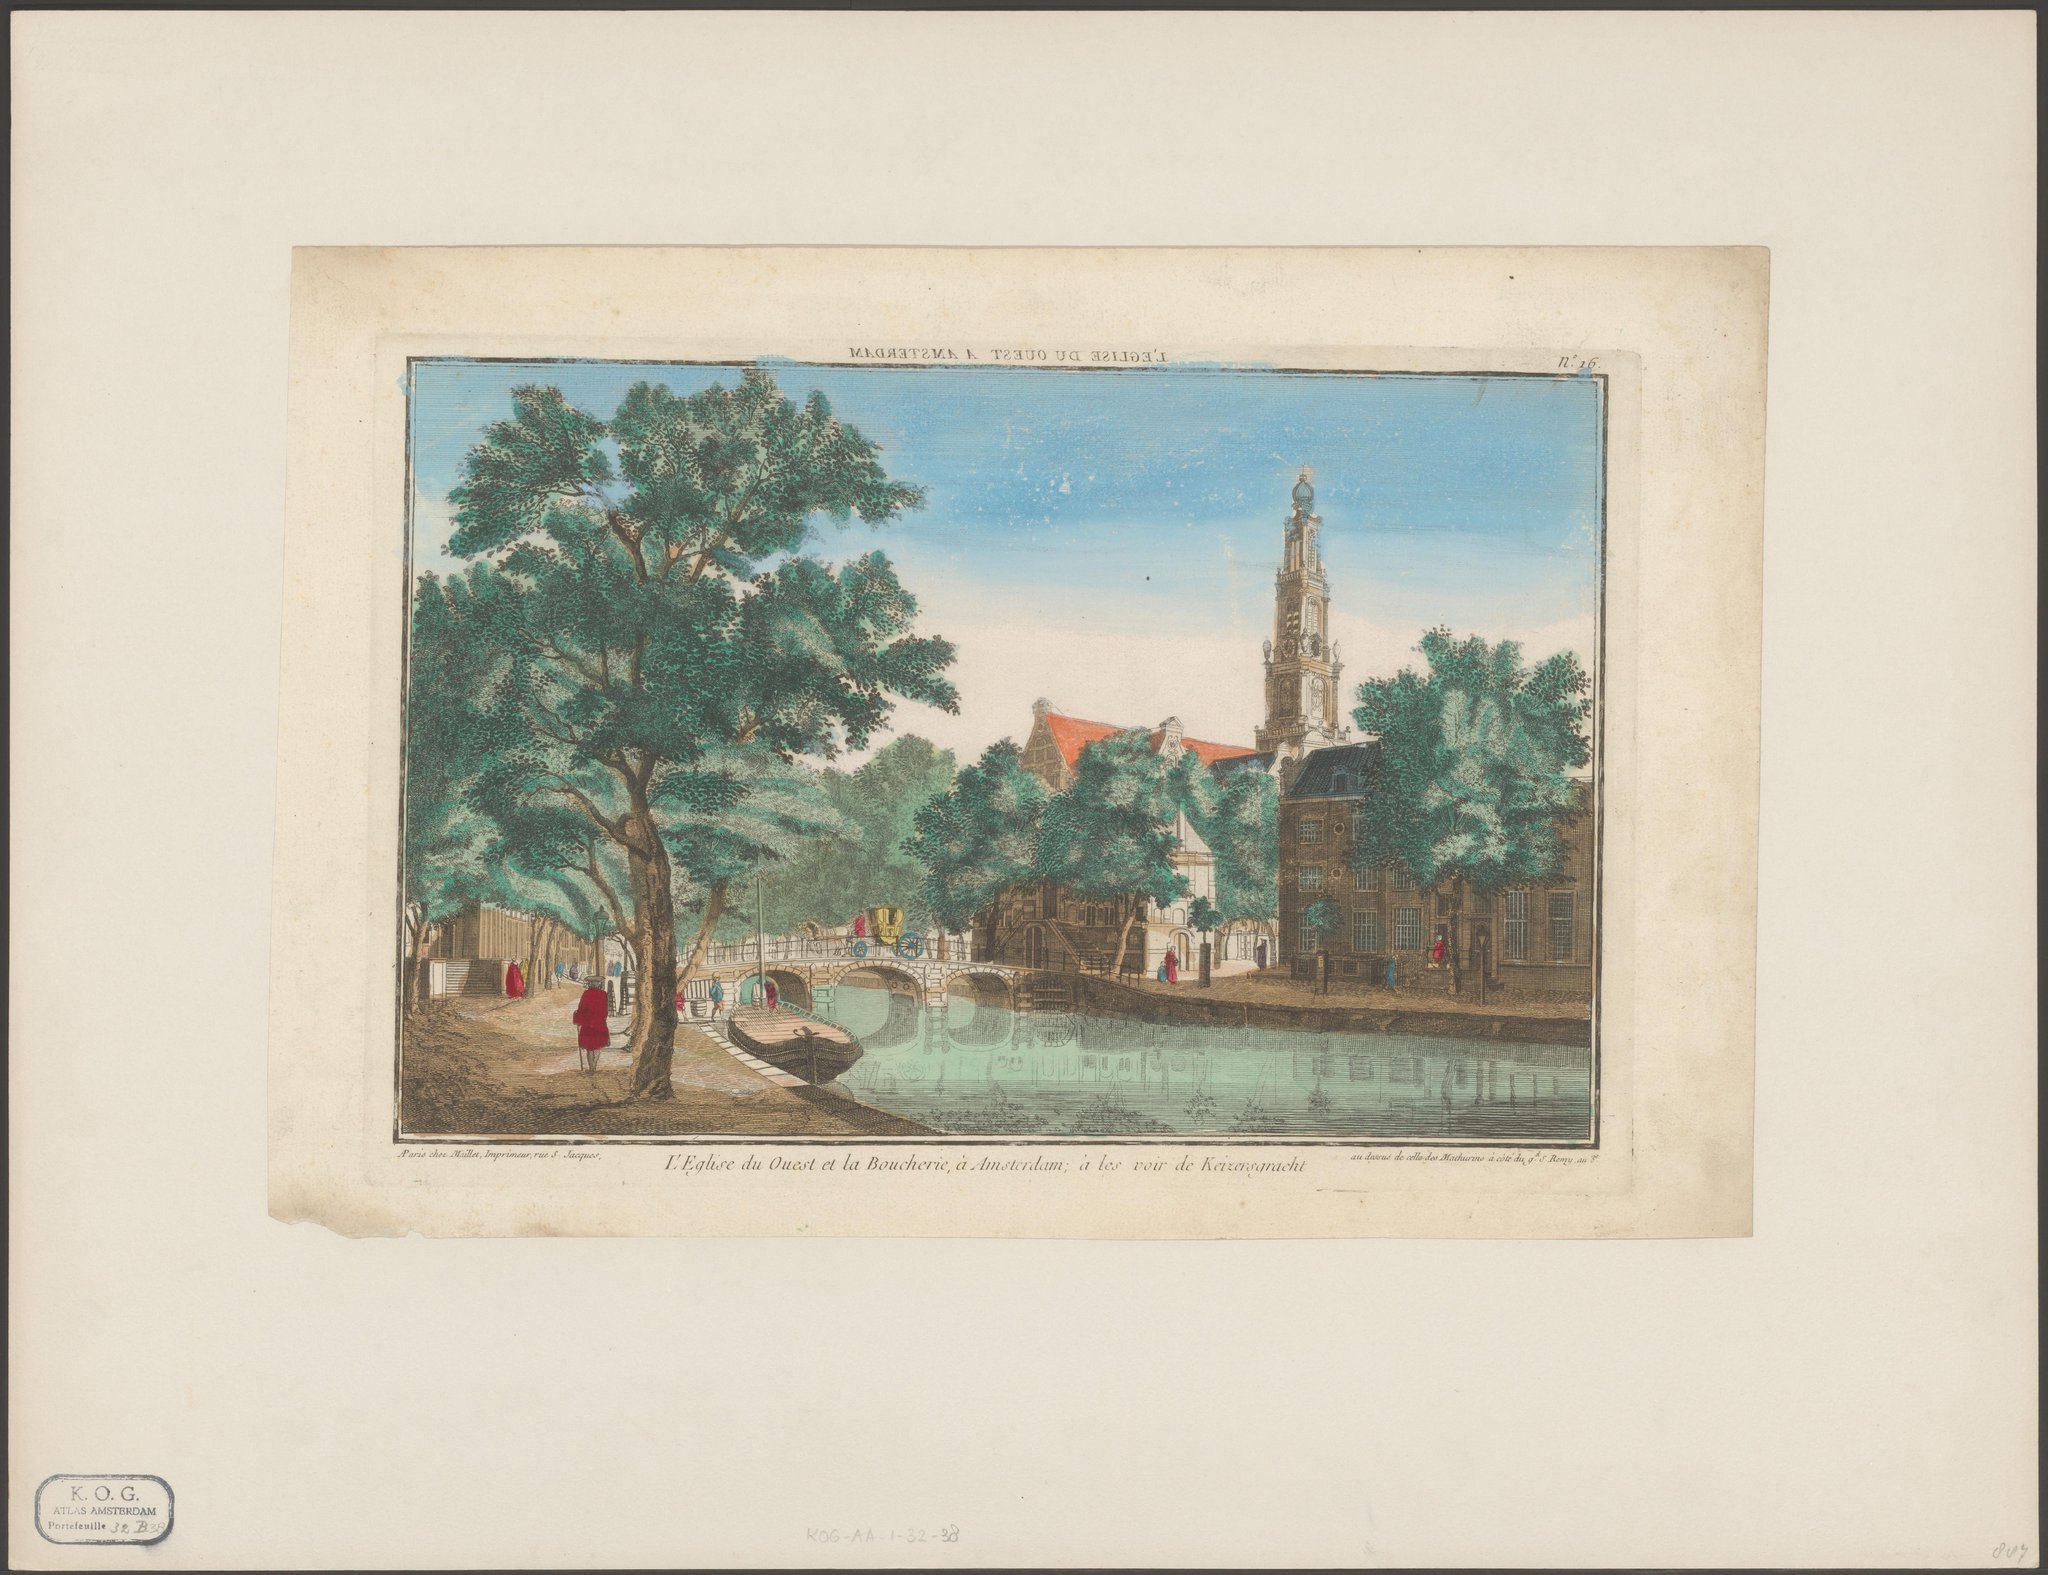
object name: opticaprent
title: Gezicht op de Westerkerk en Westerhal, gezien vanaf de Keizersgracht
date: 1744-1760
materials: paper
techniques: etching, hand coloring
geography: france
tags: bridge in city across river, canal, etc. (+ city(-scape) with figures, staffage), church (exterior), canals, waters (in city), weigh-house, market-hall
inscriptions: collector's mark: ‘32B.38’ Lugt 1641b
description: Rechtsboven genummerd: No. 16. Onderwerpsrubriek binnen de Atlas Amsterdam: Kerkwezen: Hervormde Gemeente: Westerkerk.